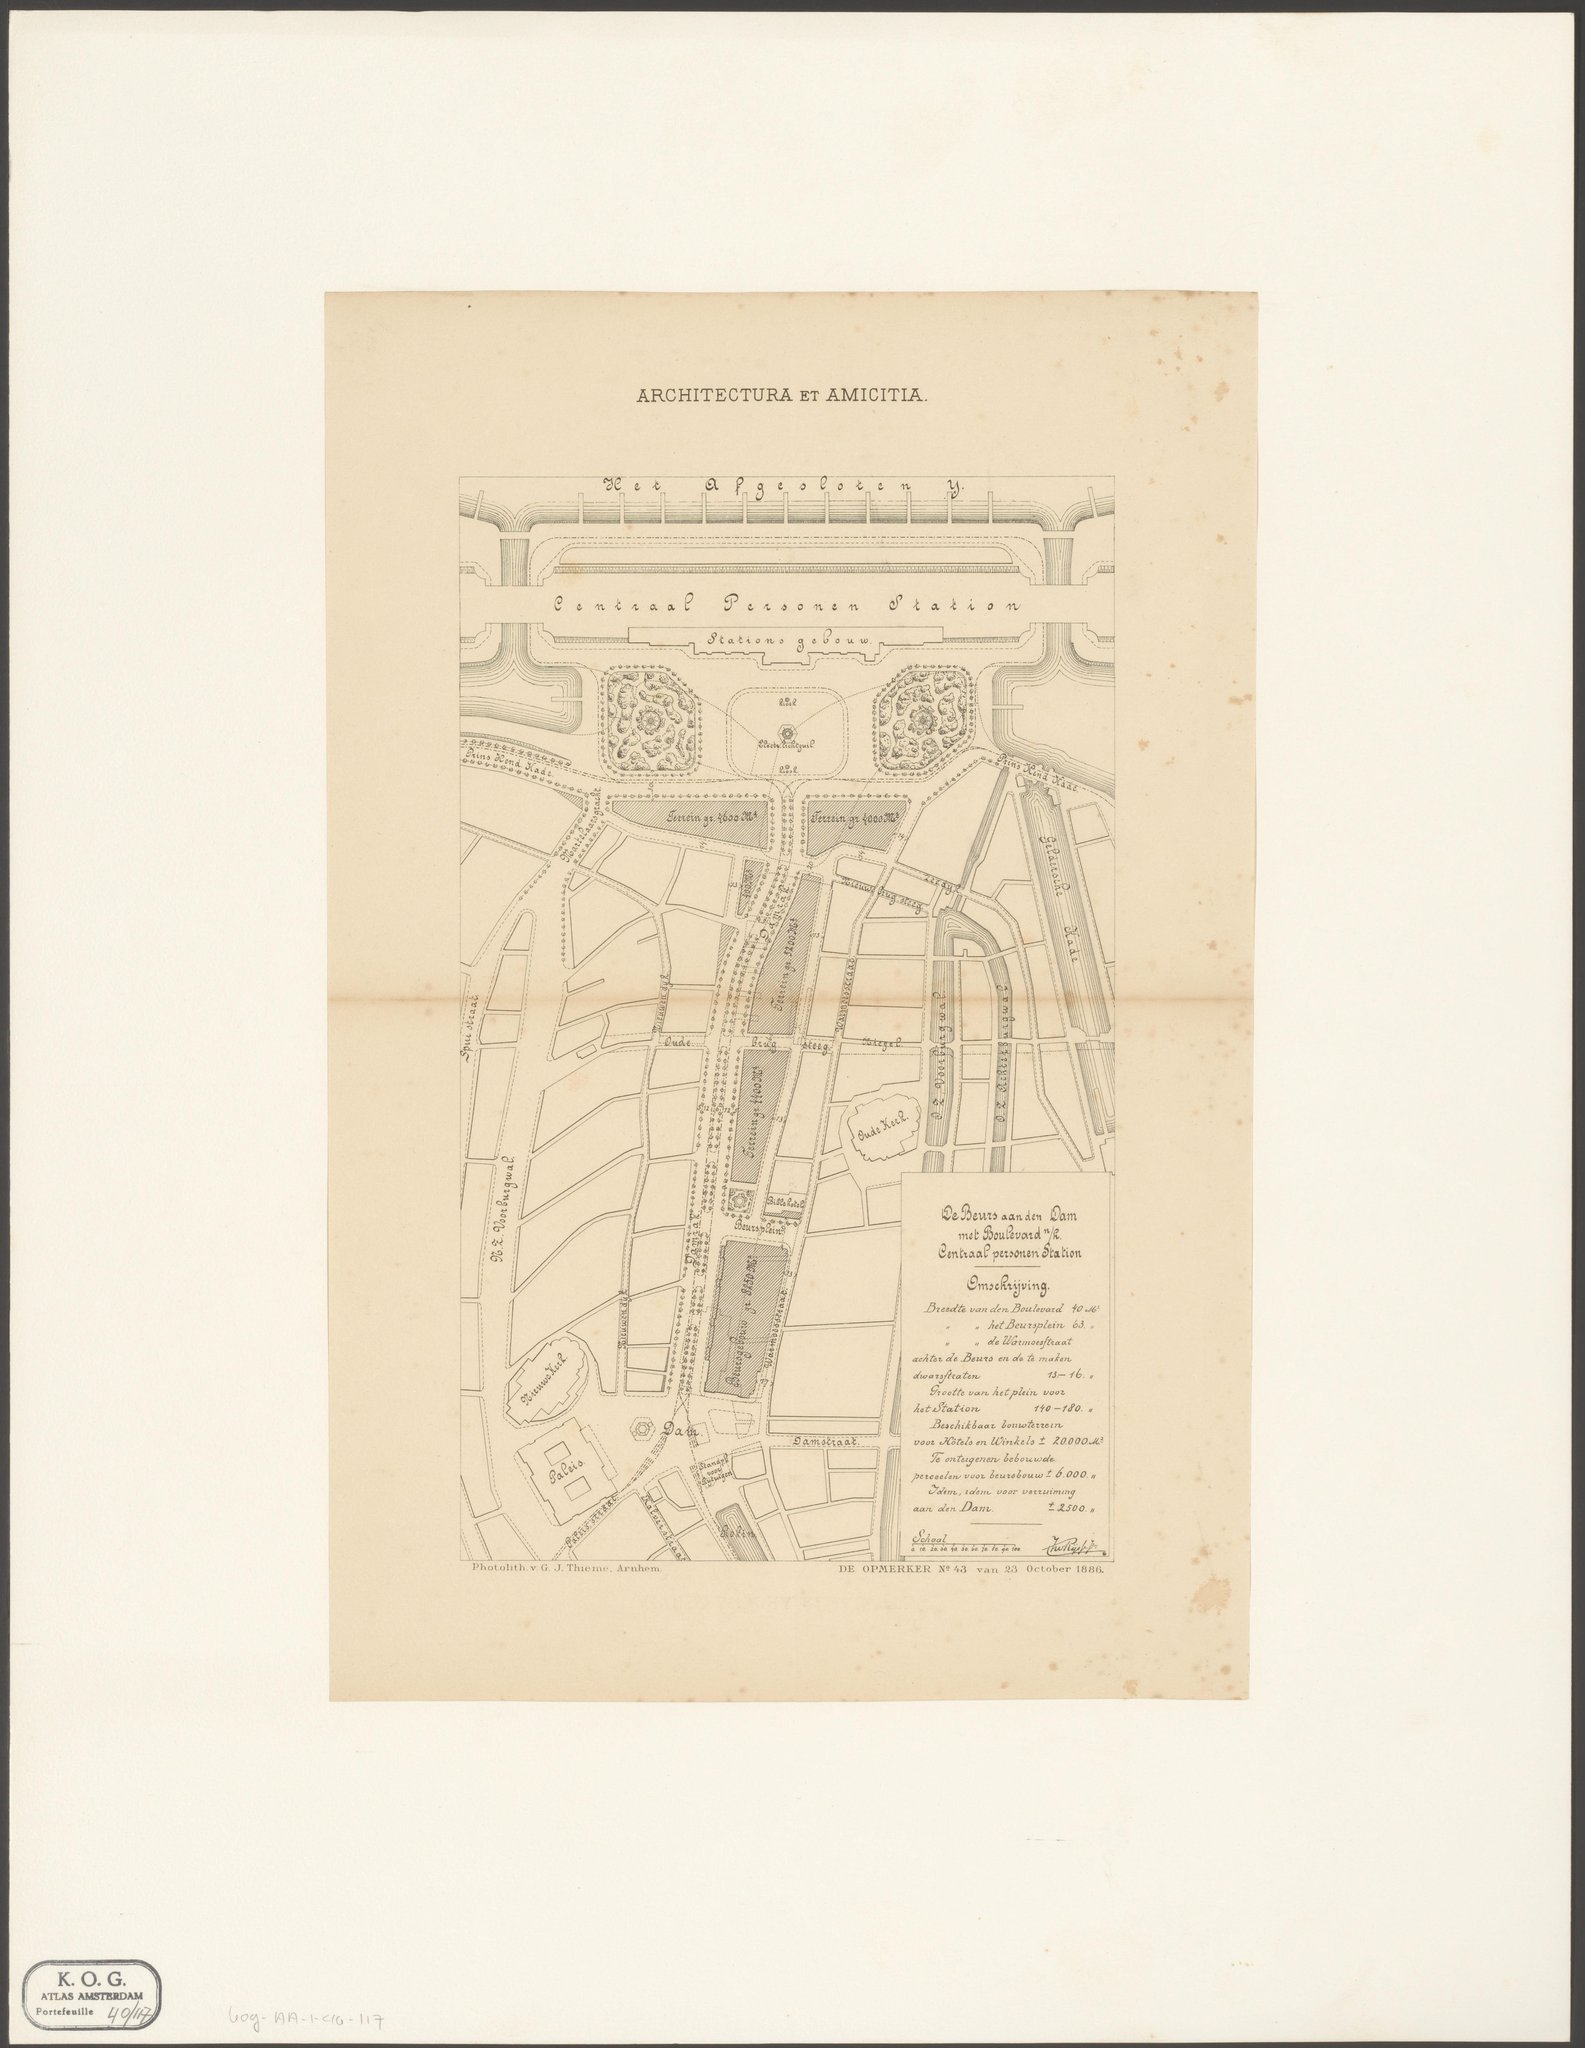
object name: photomechanical print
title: De Beurs aan den Dam met Boulevard n/h Centraal personen Station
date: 1886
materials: paper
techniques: photolithography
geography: arnhem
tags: stock exchange, stock-market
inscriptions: collector's mark: Lugt 1641b, signature: ‘Z.v.Rijsse Jr.’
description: Onderwerpsrubriek binnen de Atlas Amsterdam: Handel en Zeevaart, D. Beurs-Ontwerpen.